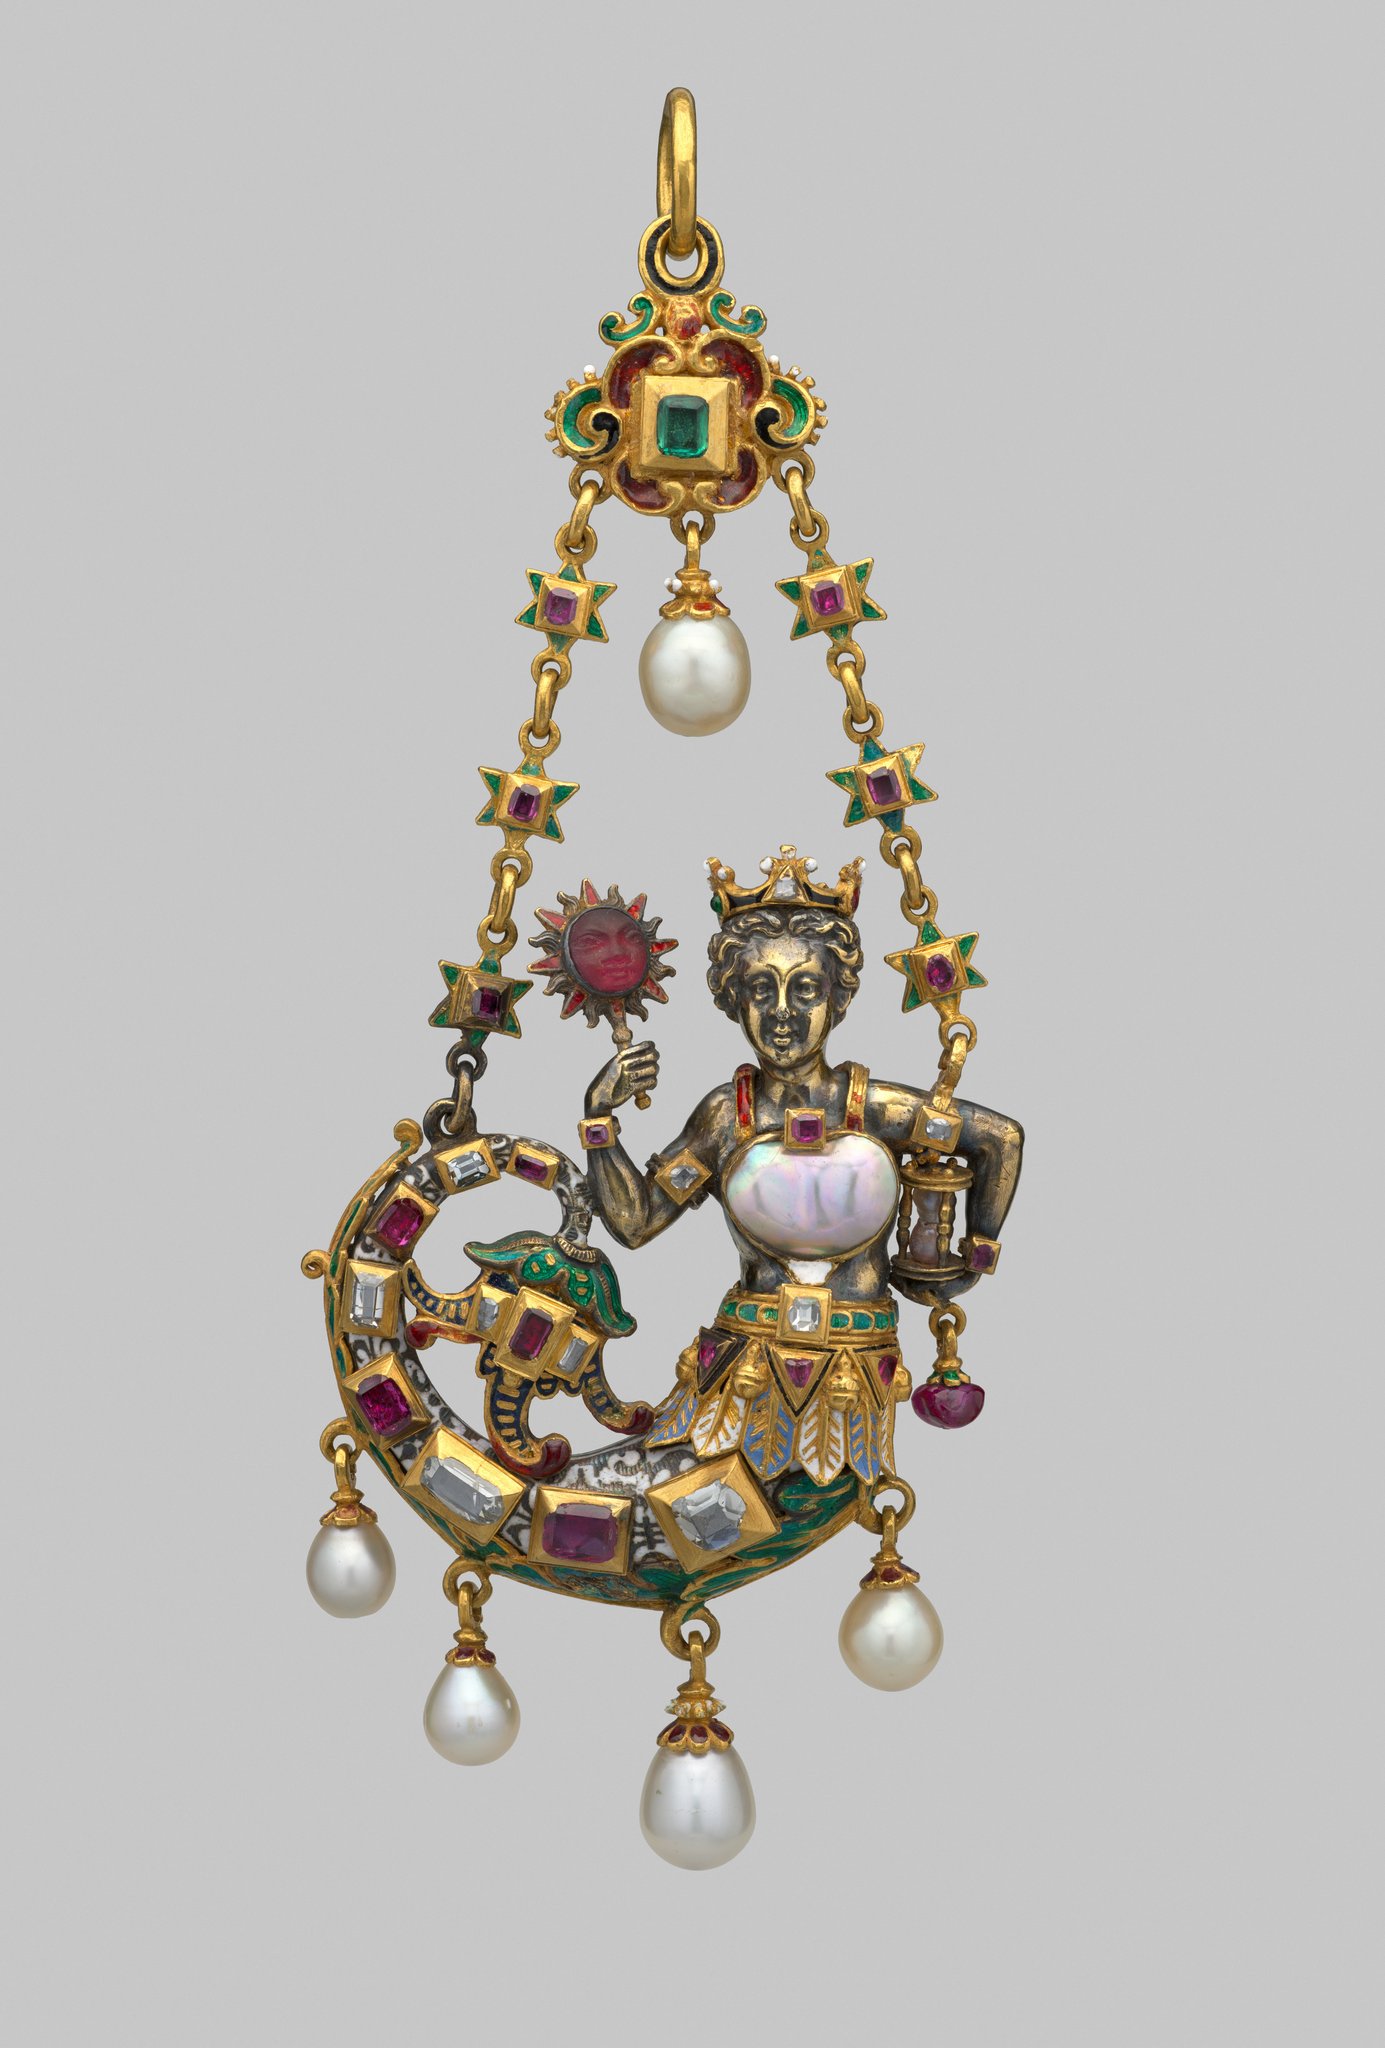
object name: pendant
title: Sixteenth-century-style pendant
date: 1801-1900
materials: enamel, gold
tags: mermaids